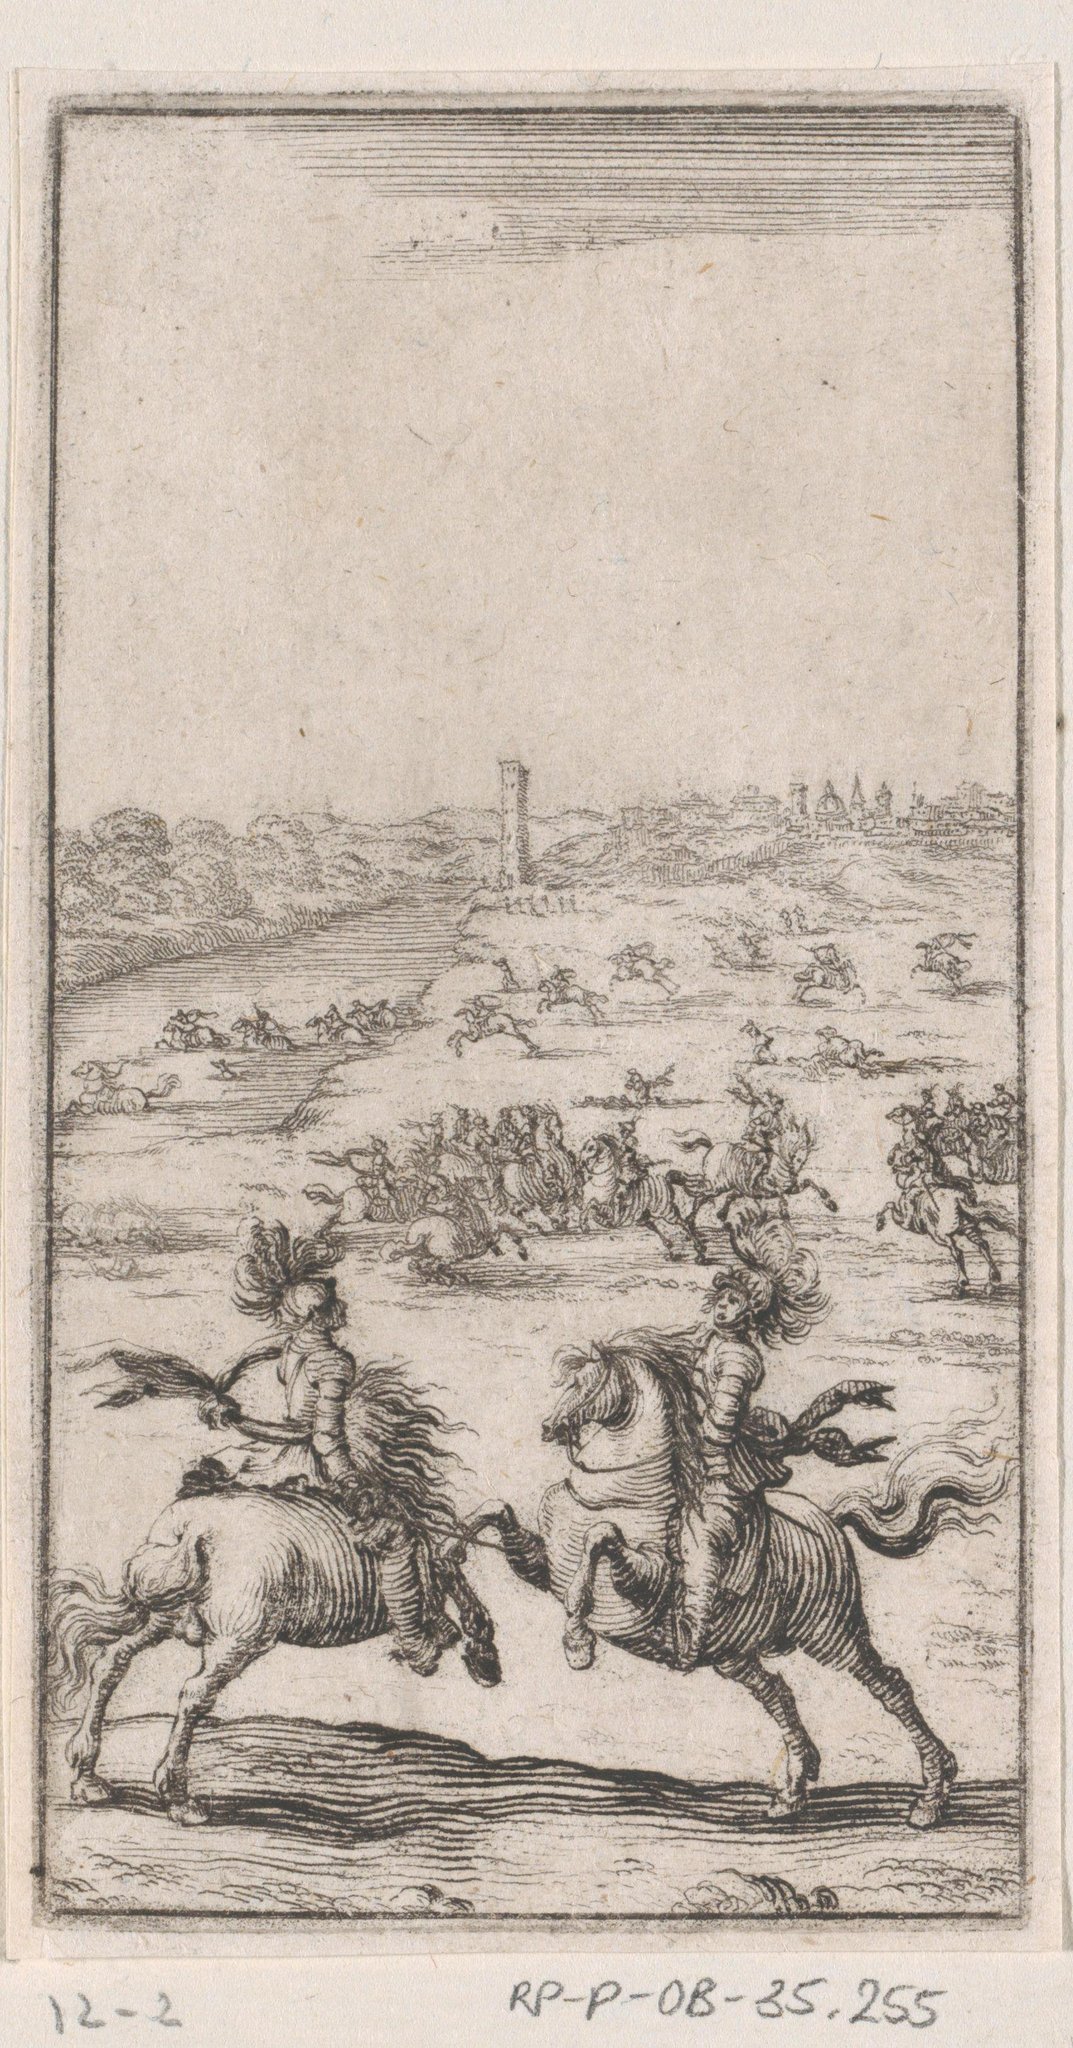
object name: print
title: Twaalf verschillende scènes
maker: Anonymous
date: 1620-1664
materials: paper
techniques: etching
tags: battle, warfare; military affairs (+ cavalry, horsemen), the soldier; the soldier's life, knight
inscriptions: collector's mark: Lugt 240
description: Op de voorgrond twee ridders te paard in gevecht. Op de achtergrond een slagveld en een gezicht op een stad.